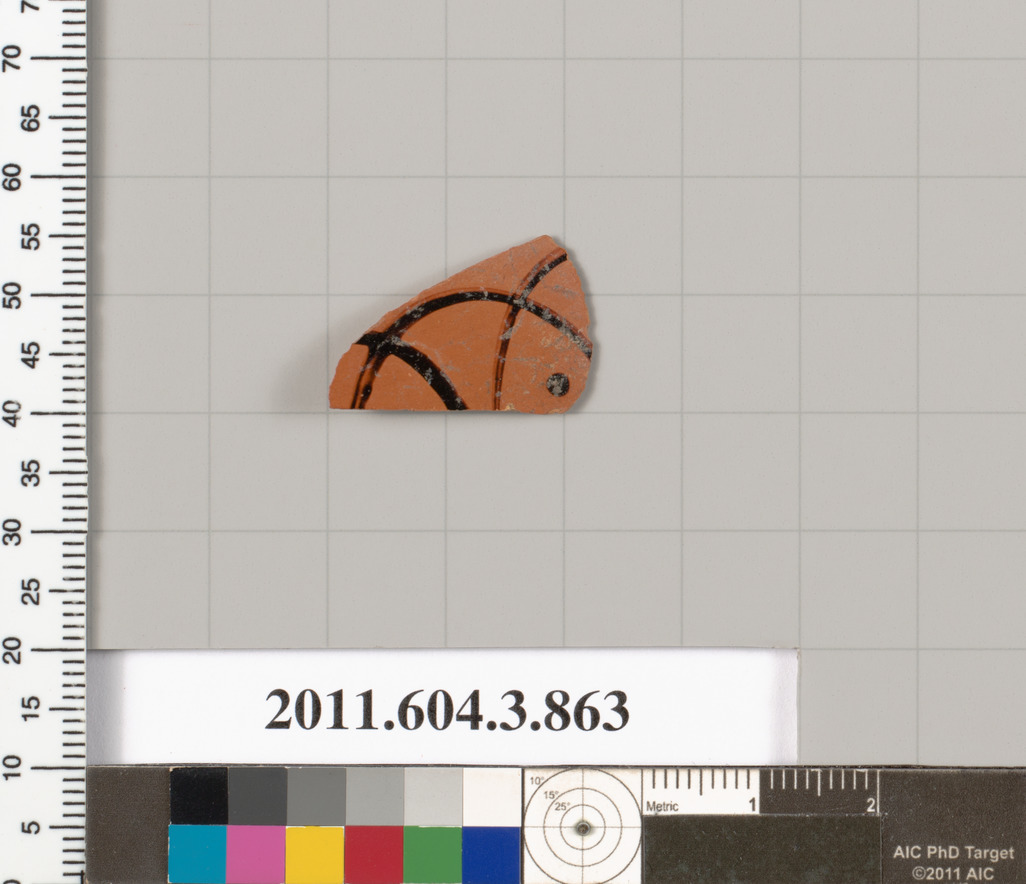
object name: lekythos fragment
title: Terracotta fragment of a lekythos (oil flask)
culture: greek, attic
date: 534-468 BCE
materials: terracotta